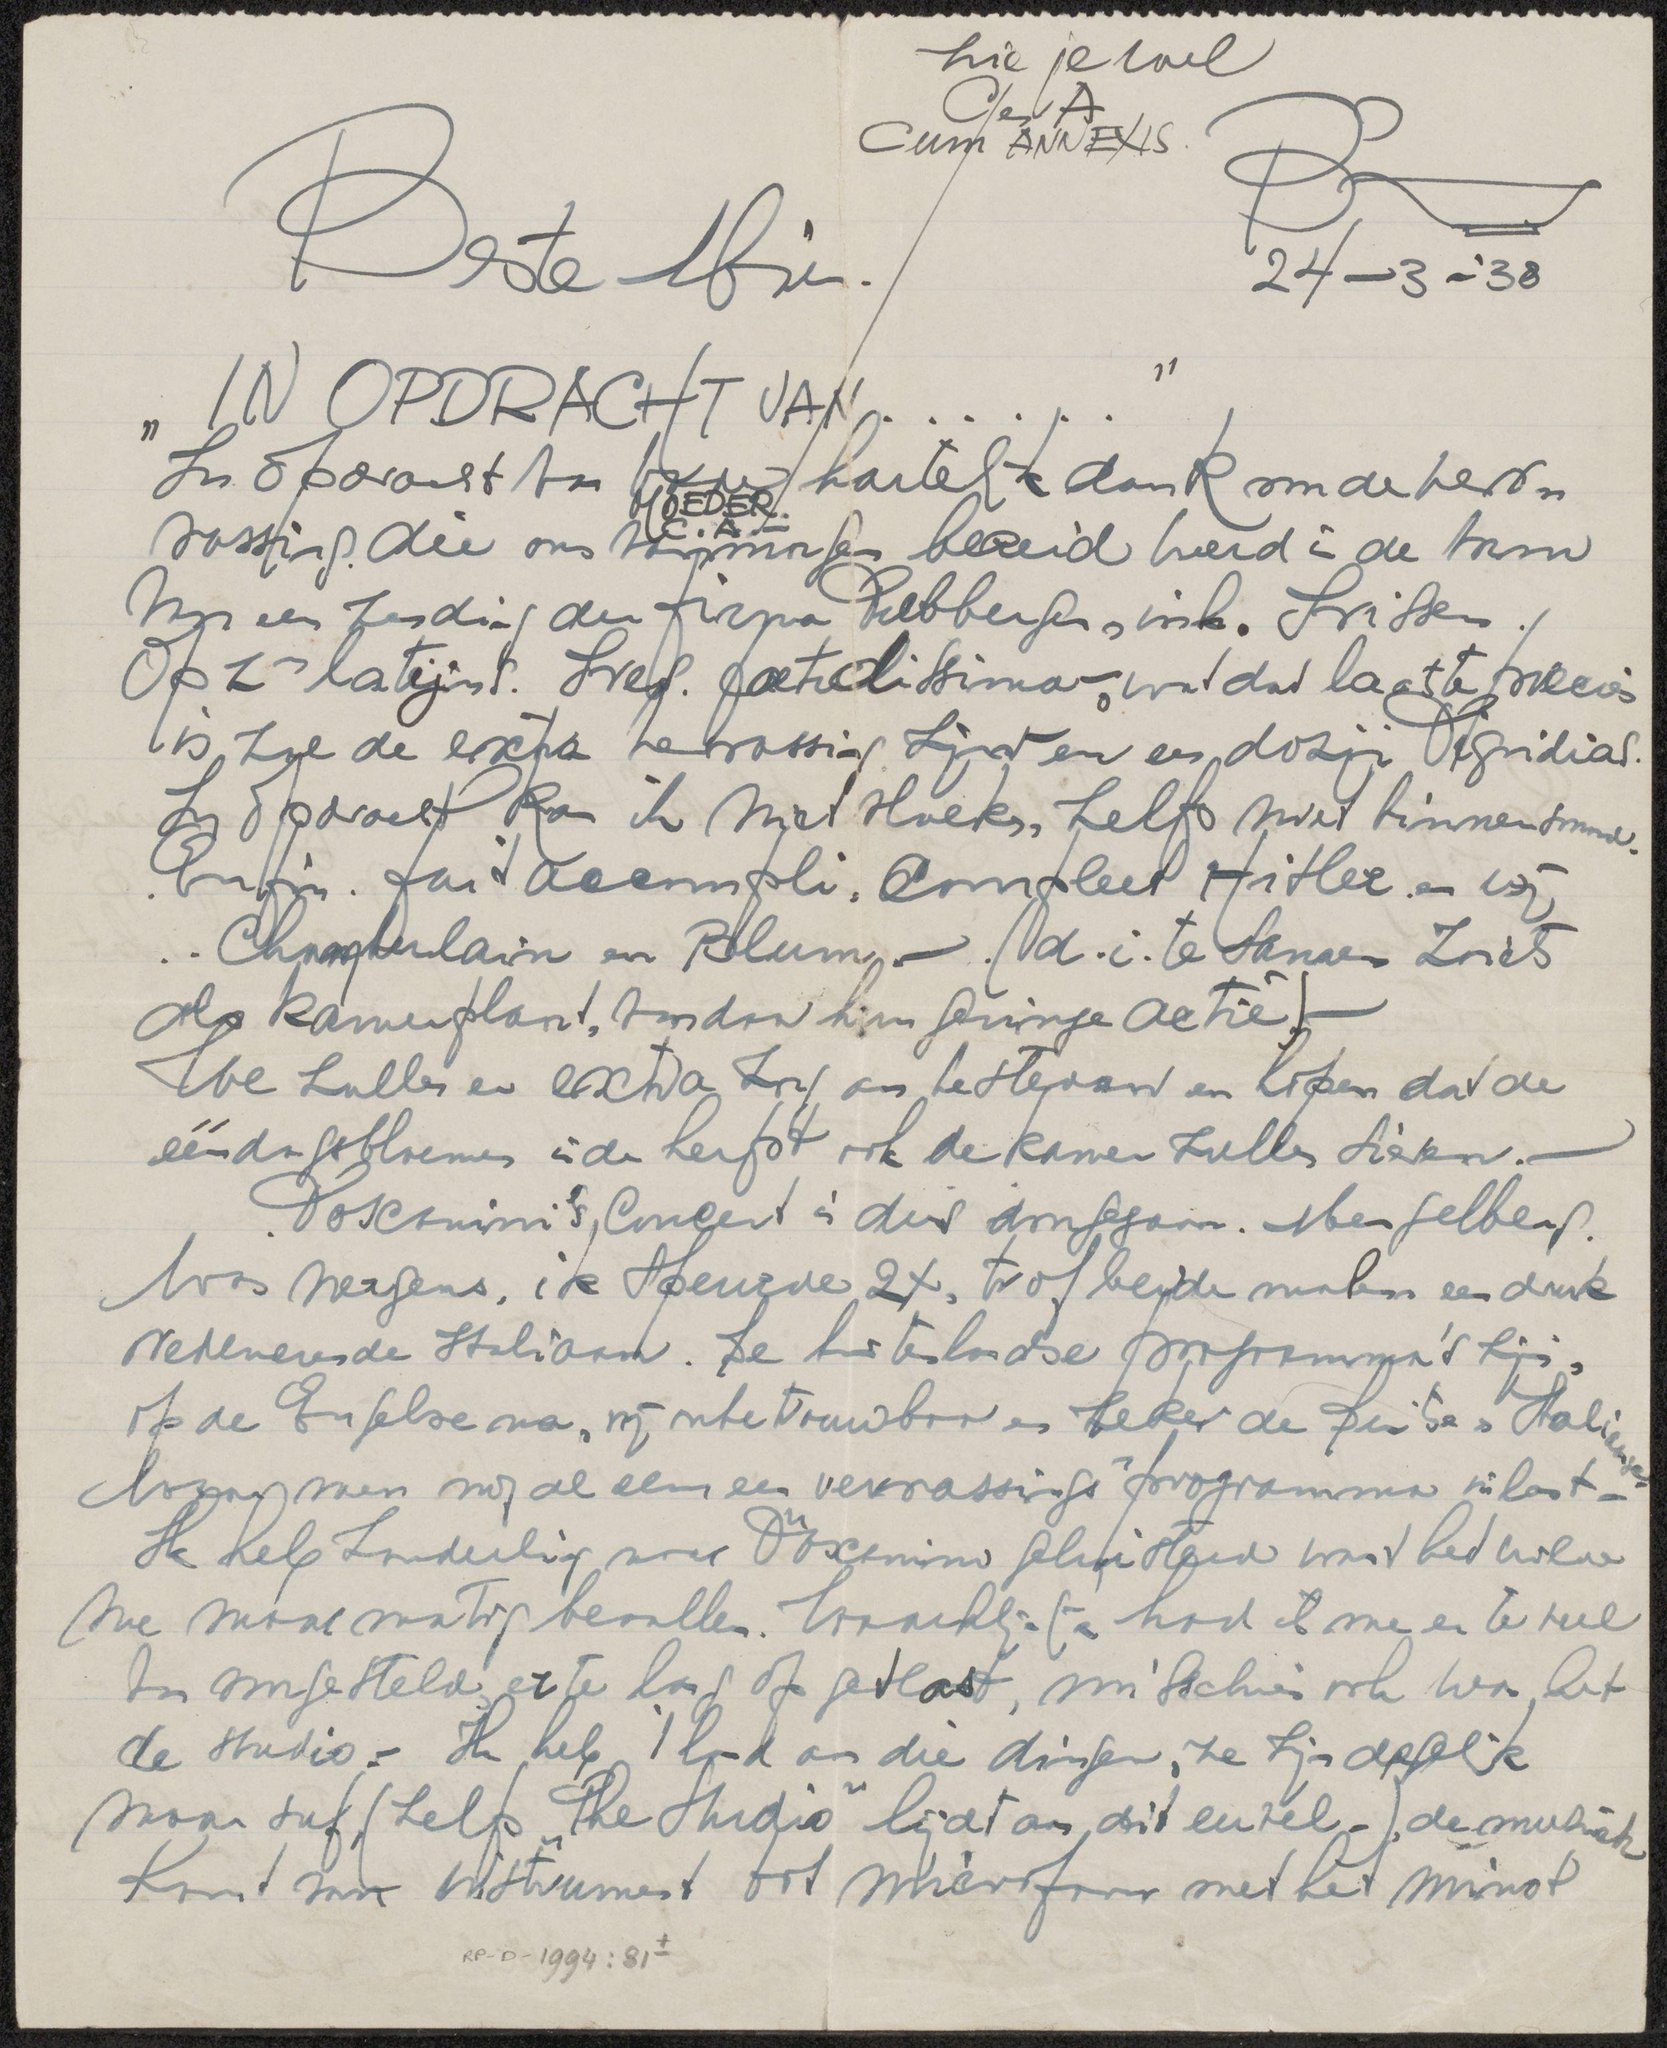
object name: letter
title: Brief aan Mien Cambier van Nooten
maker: dick ket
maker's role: draughtsman, print maker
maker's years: 1902-1940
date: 1938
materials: ink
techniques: brush, pen, writing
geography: bennekom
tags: arnhem, print maker, draughtsman, mien cambier van nooten, sitting figure, music, historical persons (portraits and scenes from the life)